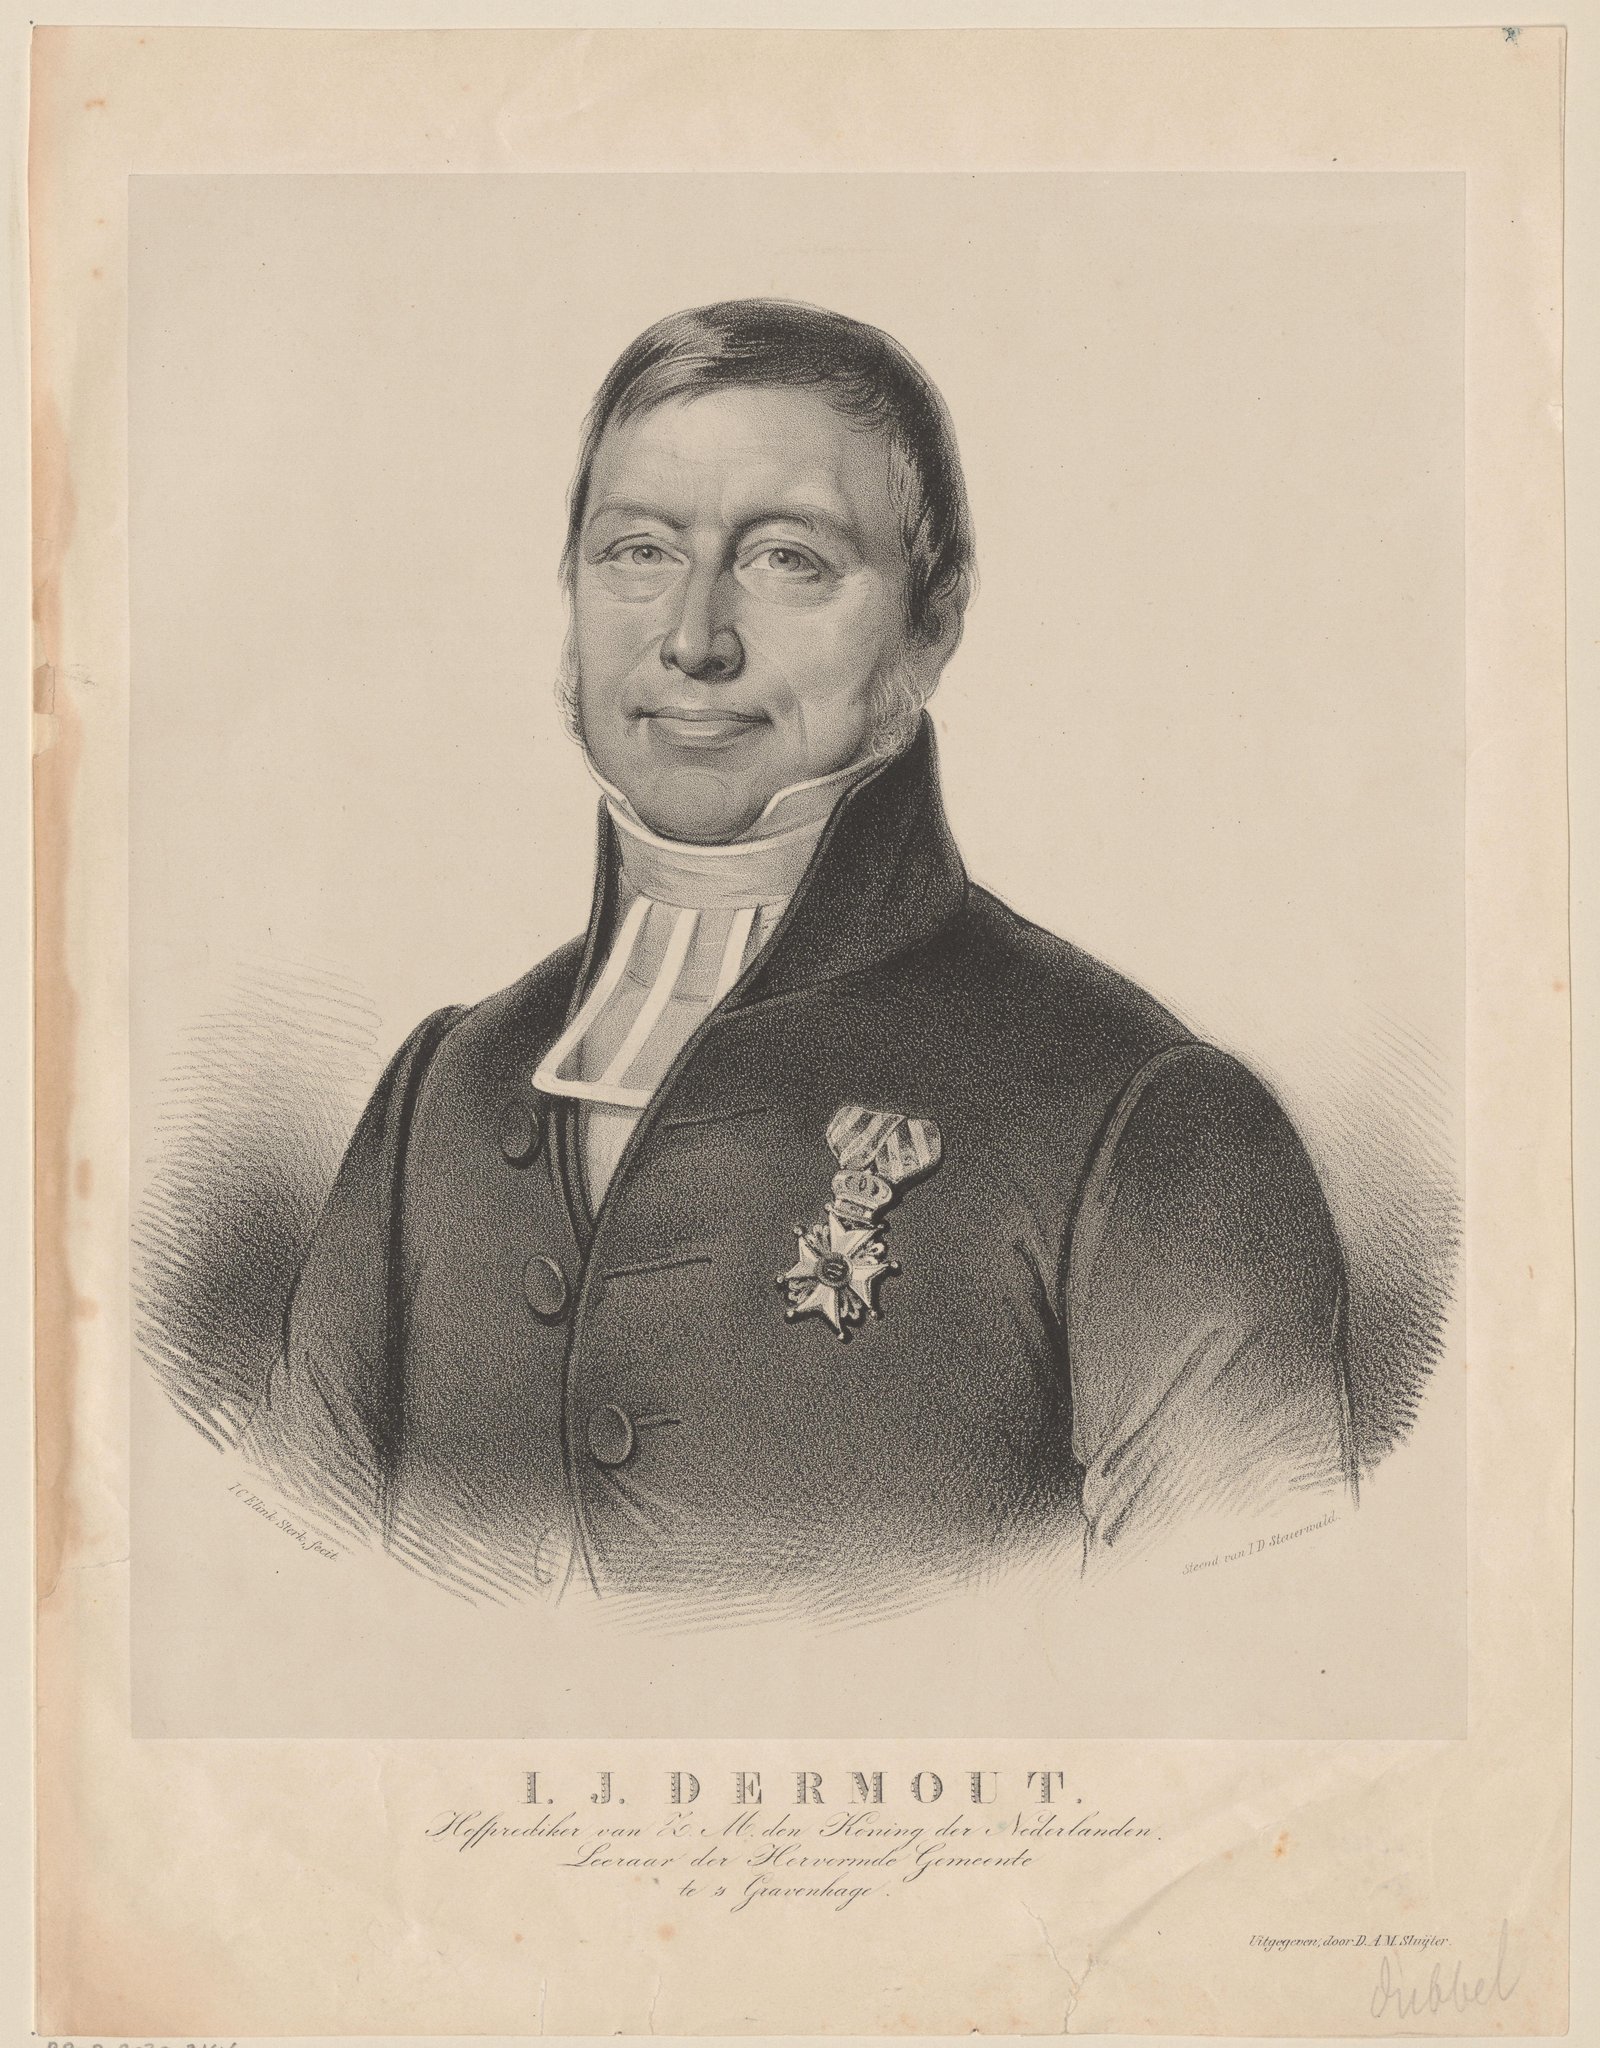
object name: print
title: Portret van Isaac Johannes Dermout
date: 1822-1831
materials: paper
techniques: lithograph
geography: the hague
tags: hoorn (north holland), the hague, organizational aspects ~ protestant churches, knighthood order, historical persons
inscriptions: collector's mark: Lugt 2228, collector's mark, collector's mark: Lugt 1096